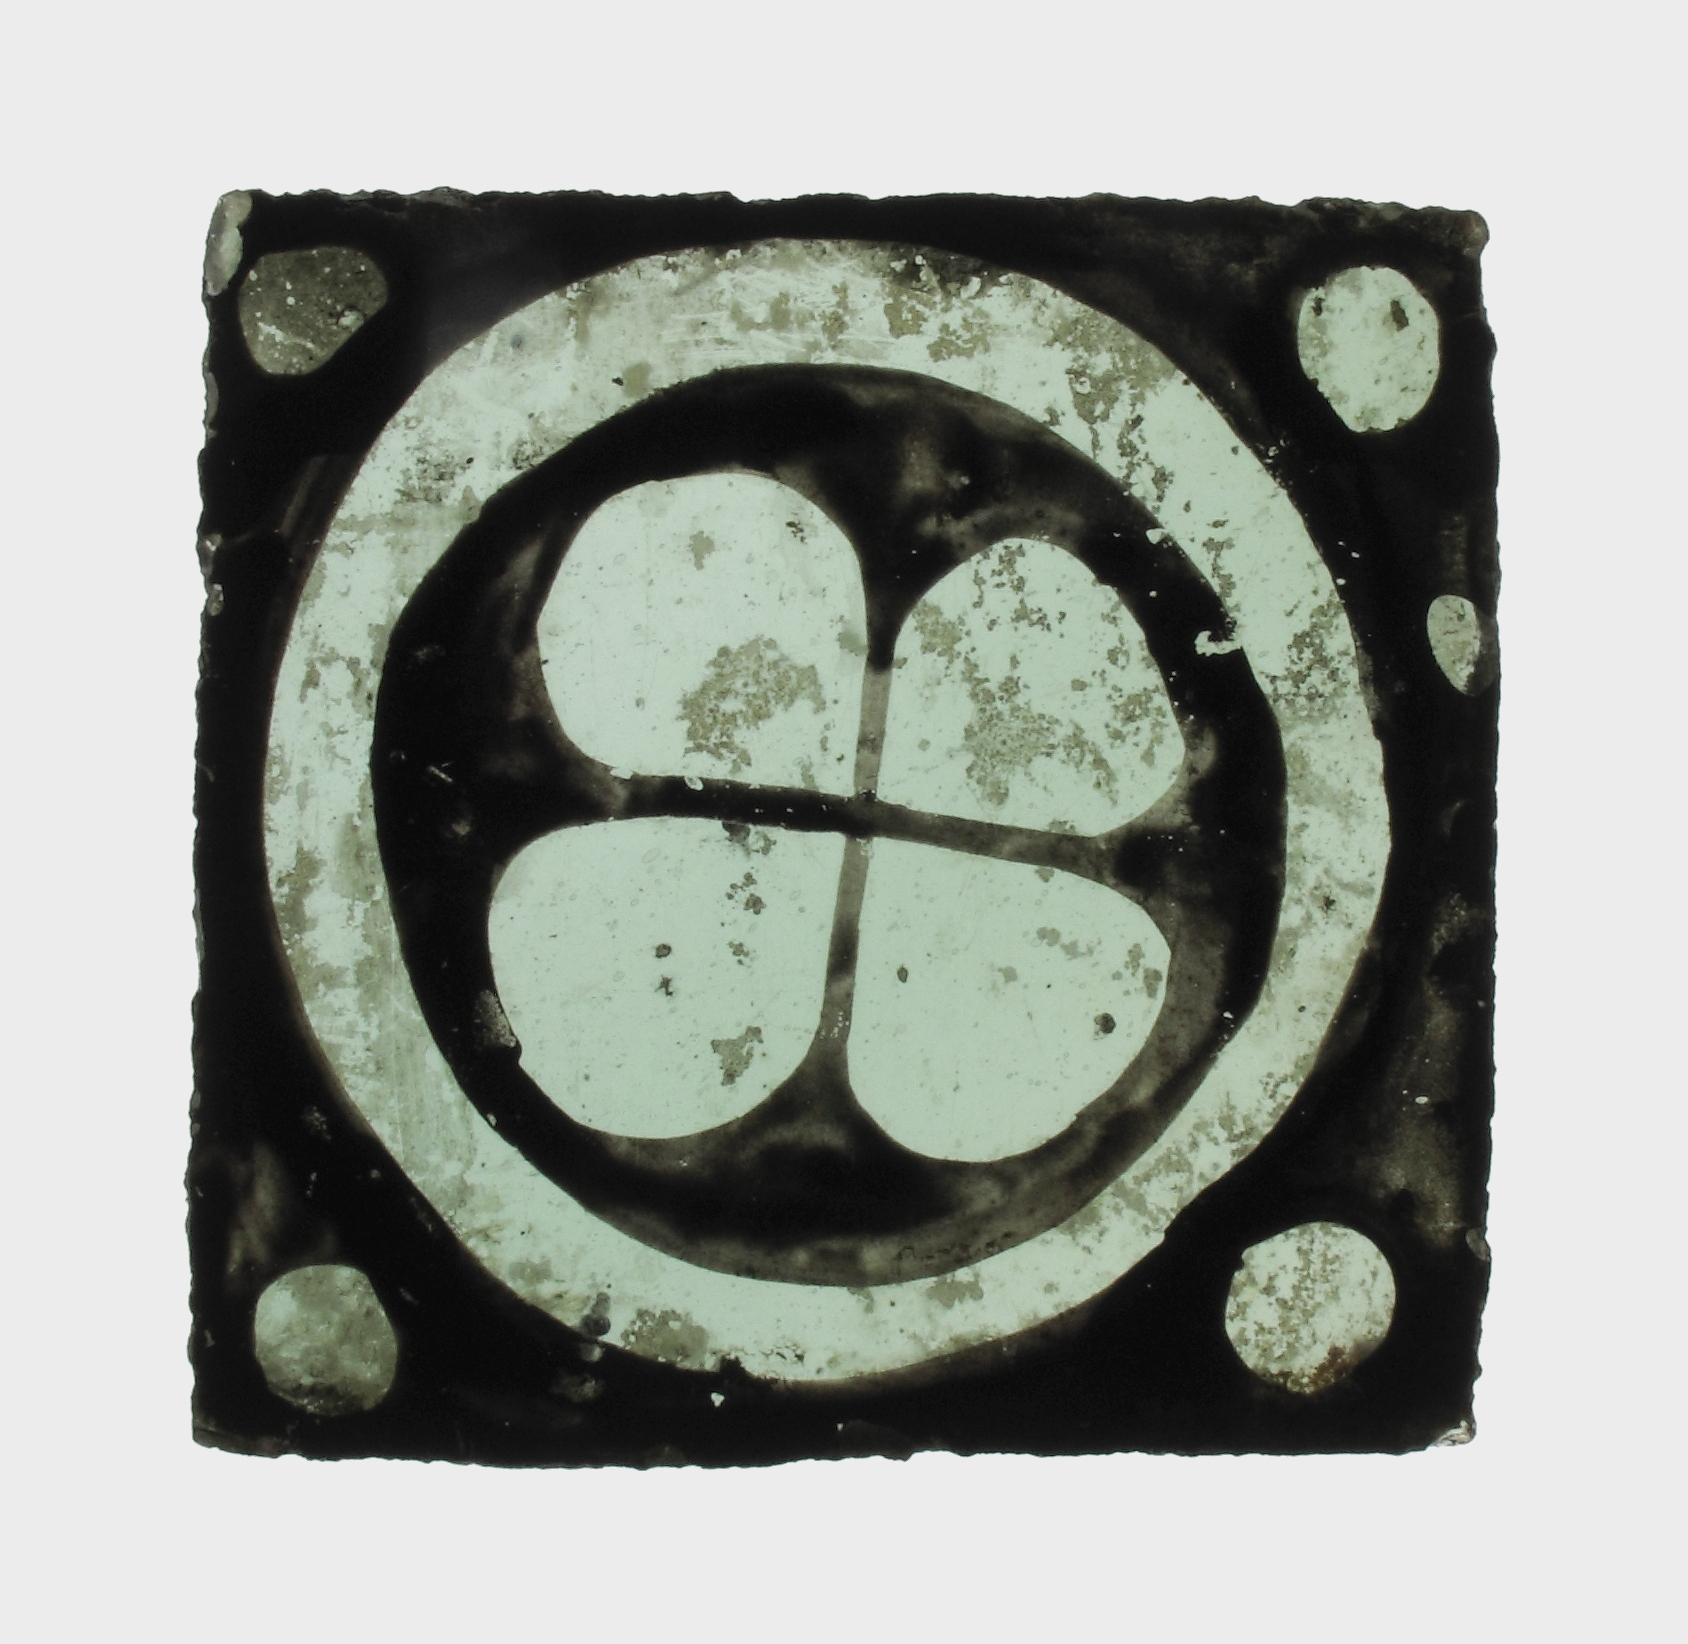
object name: fragment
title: Glass Fragment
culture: european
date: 1301-1500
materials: glass